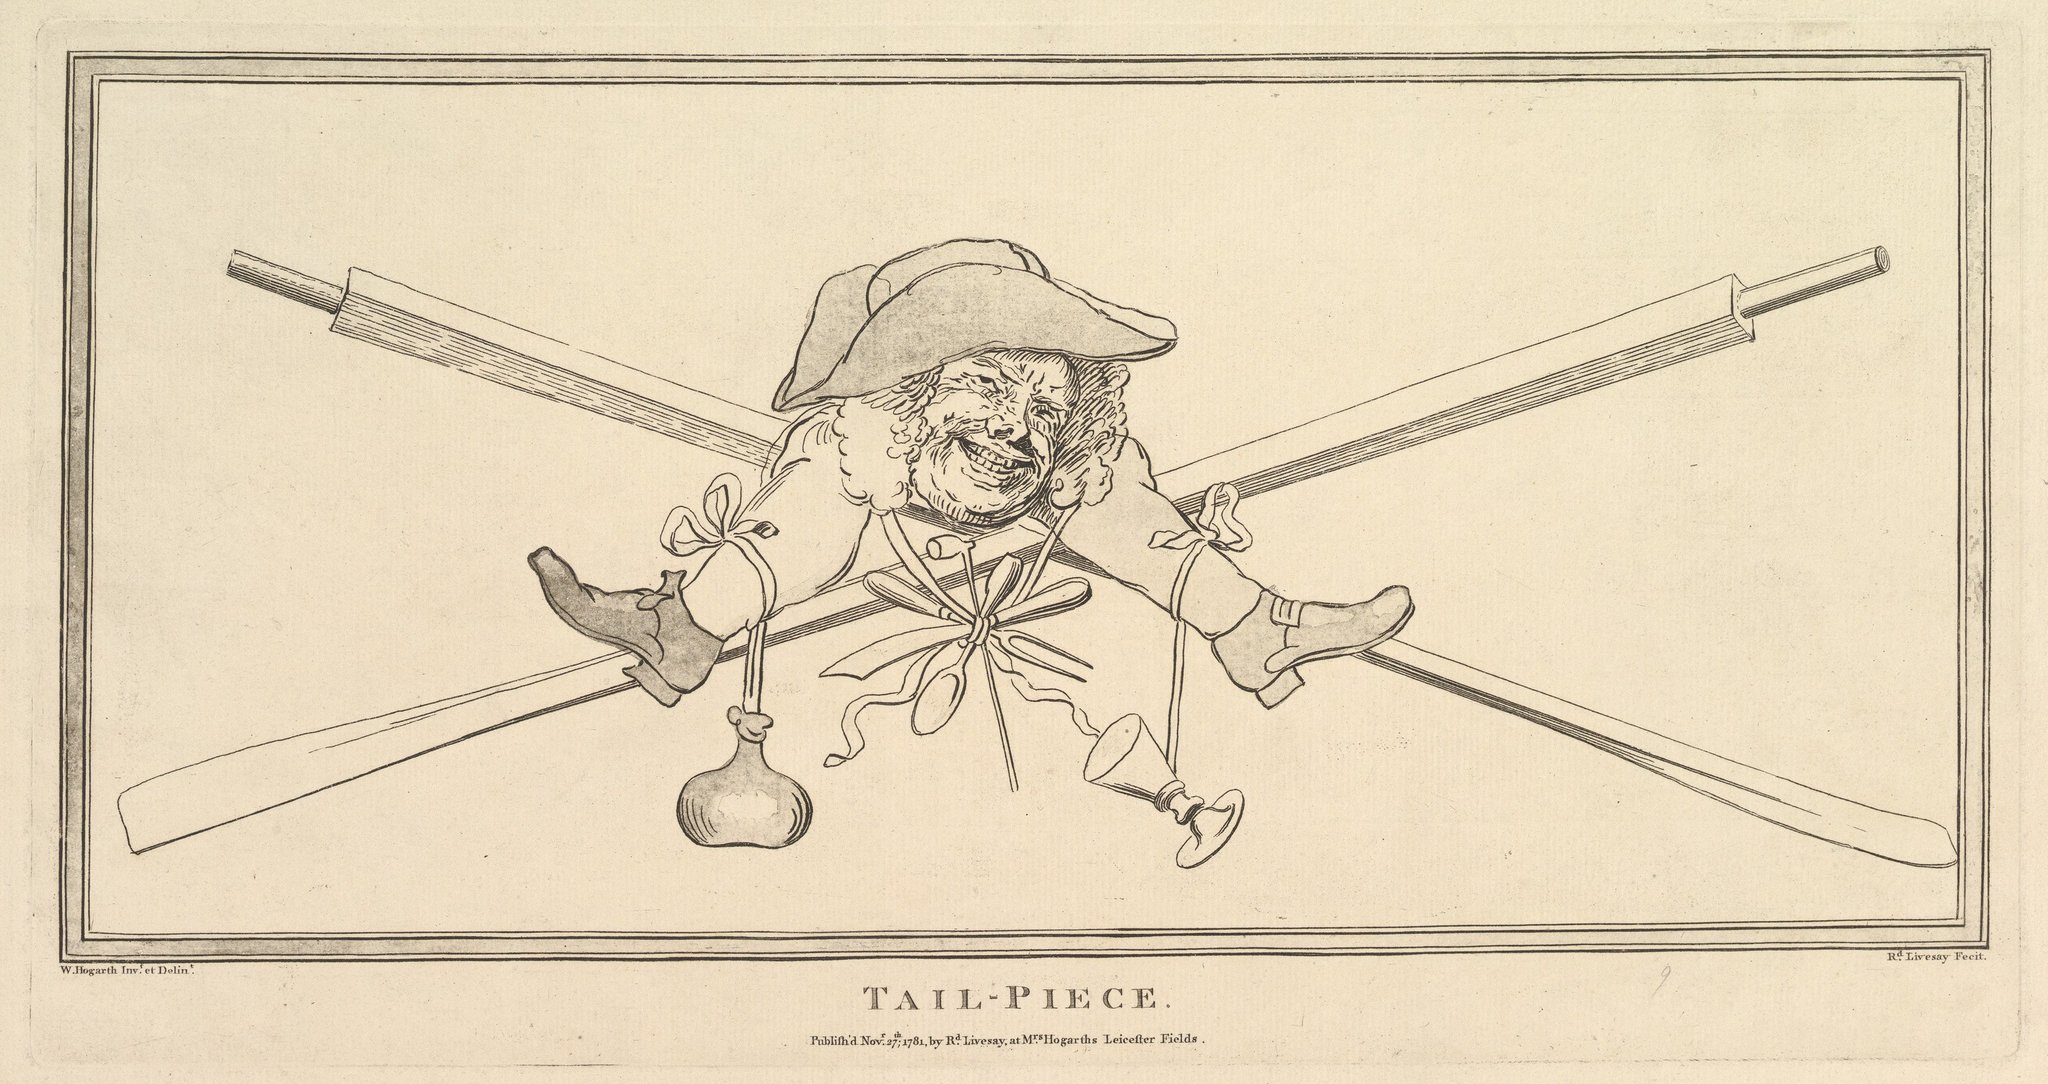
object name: print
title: Tail-Piece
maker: richard livesay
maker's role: artist and publisher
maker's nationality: british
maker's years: 1750-1826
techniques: aquatint, etching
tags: faces,men